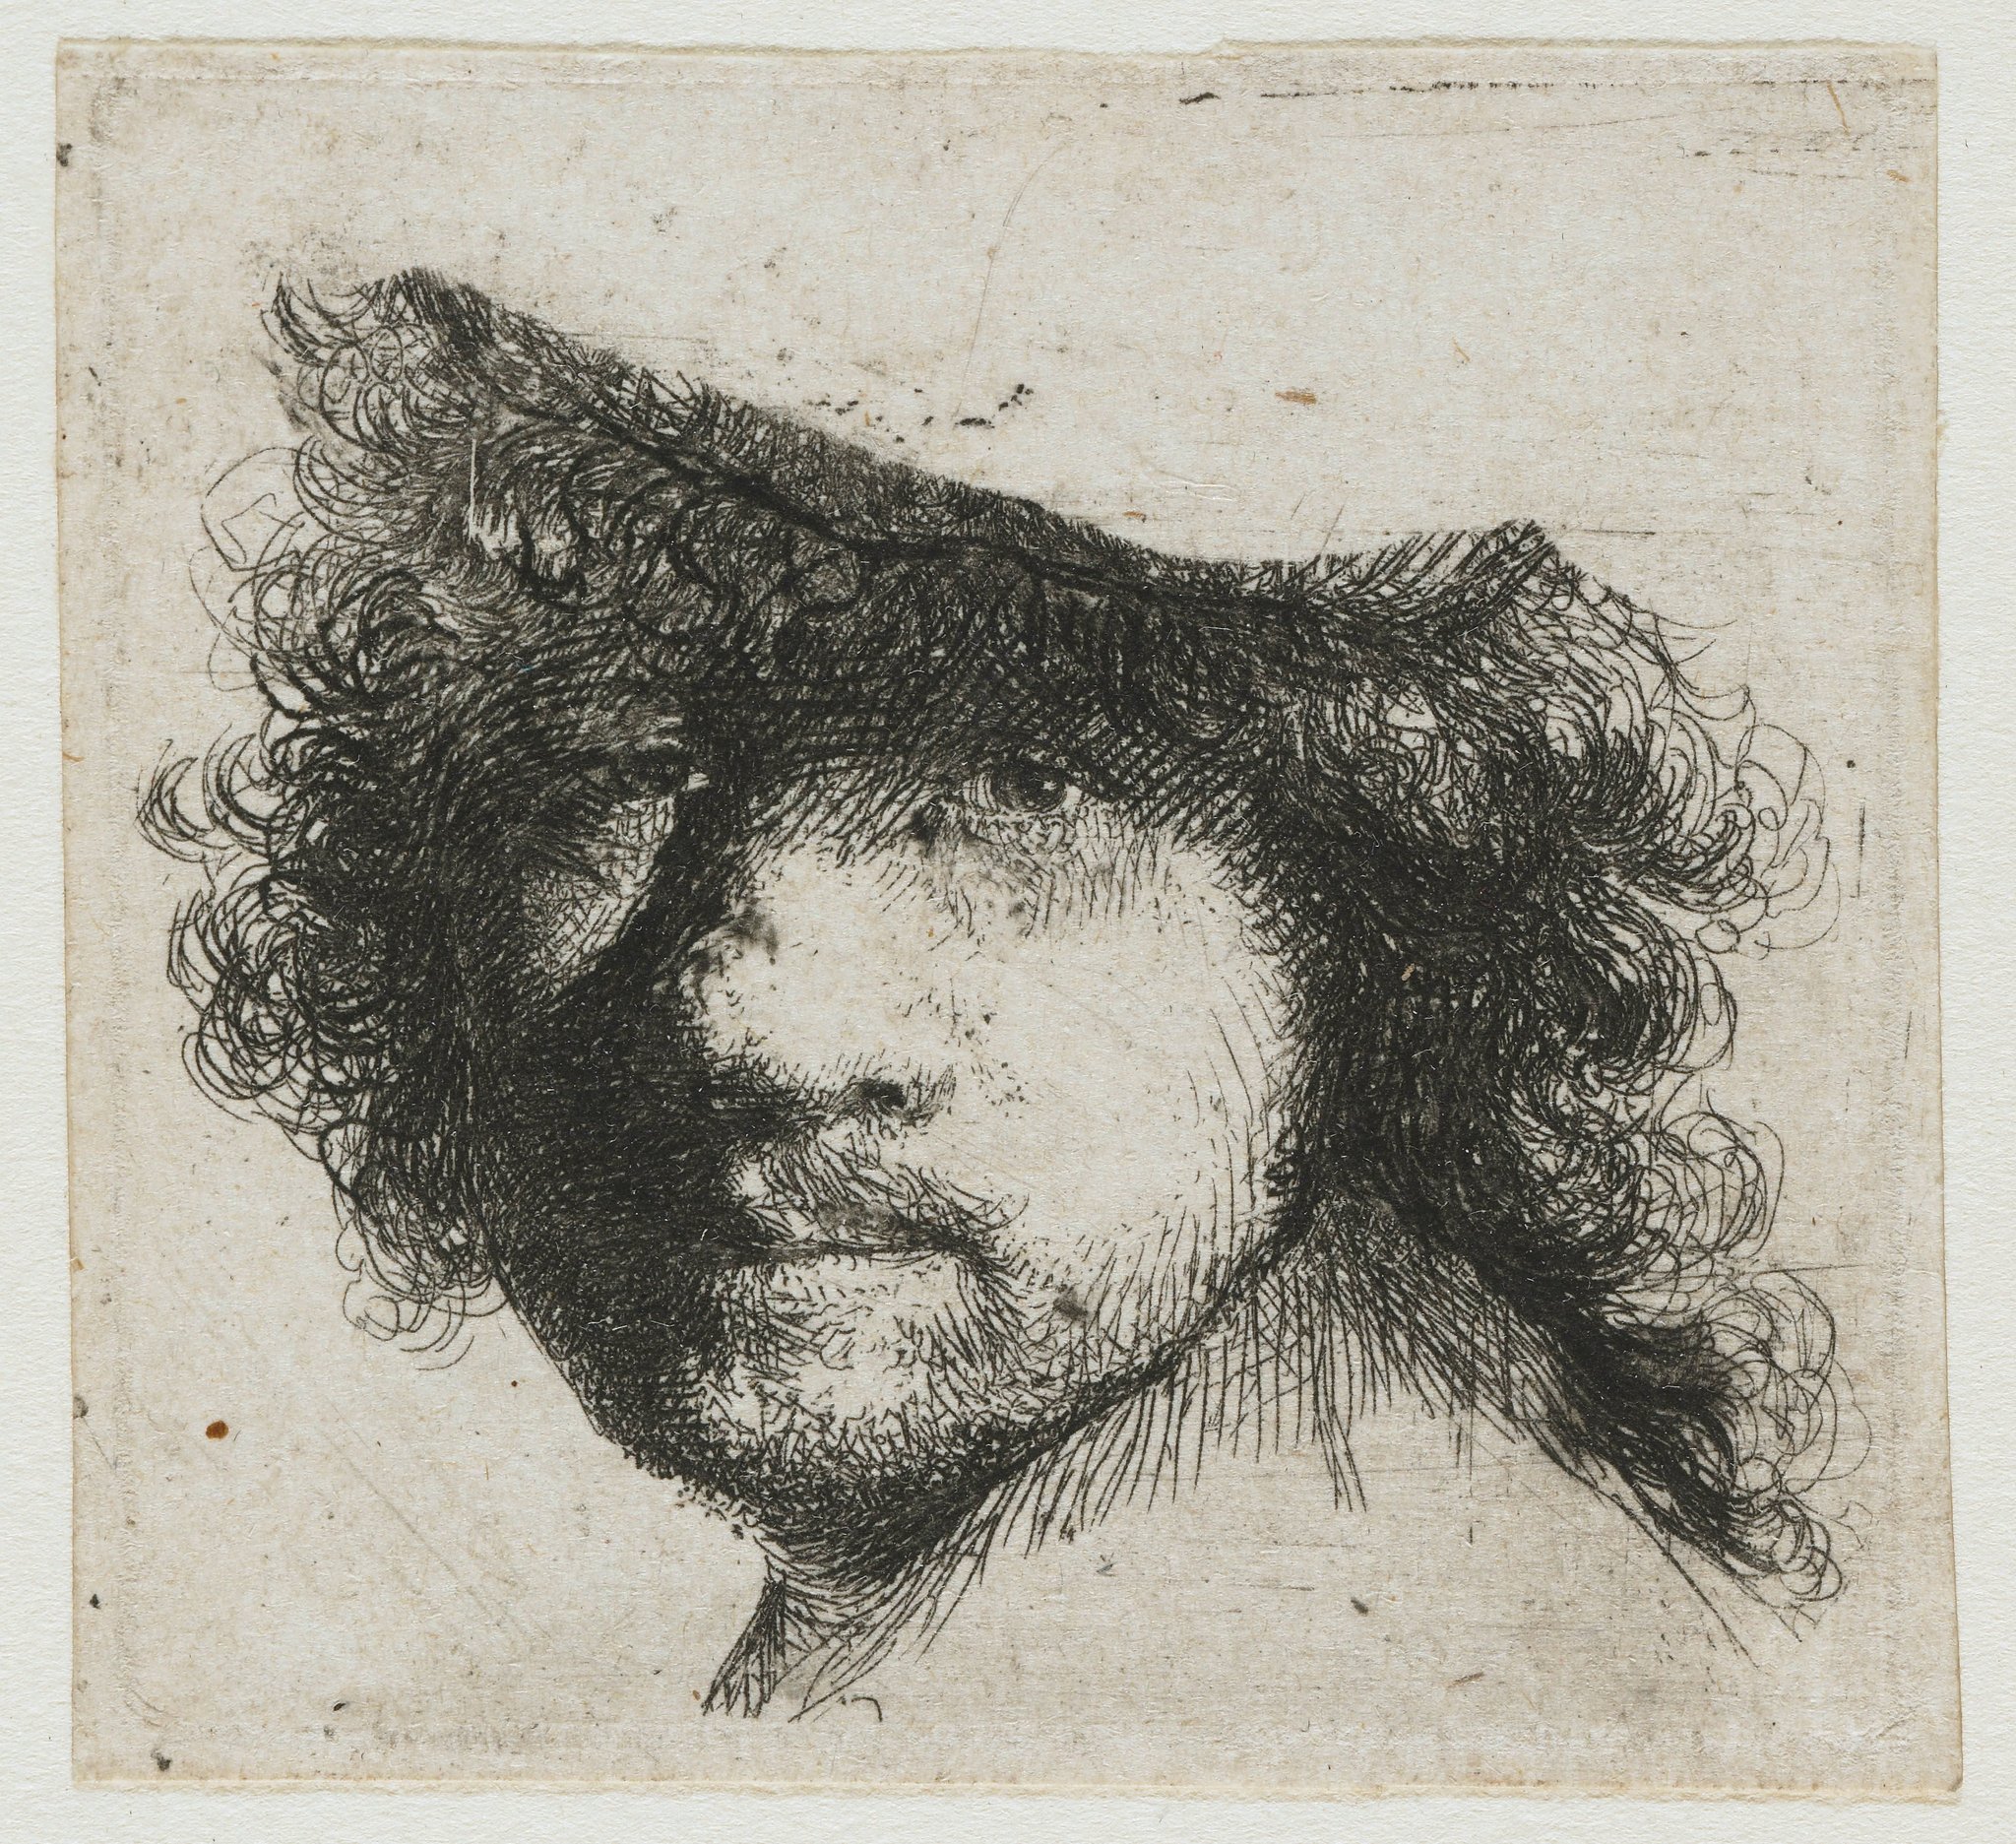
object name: print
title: Sheet of studies: head of the artist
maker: rembrandt van rijn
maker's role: draughtsman, painter, print maker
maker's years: 1606-1669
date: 1632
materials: paper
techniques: etching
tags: leiden, amsterdam, painter, print maker, rembrandt van rijn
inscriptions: collector's mark: Lugt 240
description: Uitgeknipt fragment met valse plaatranden van 'Studieblad met zelfportret, een paar bedelaars, koppen van oude man en een vrouw, etc.'